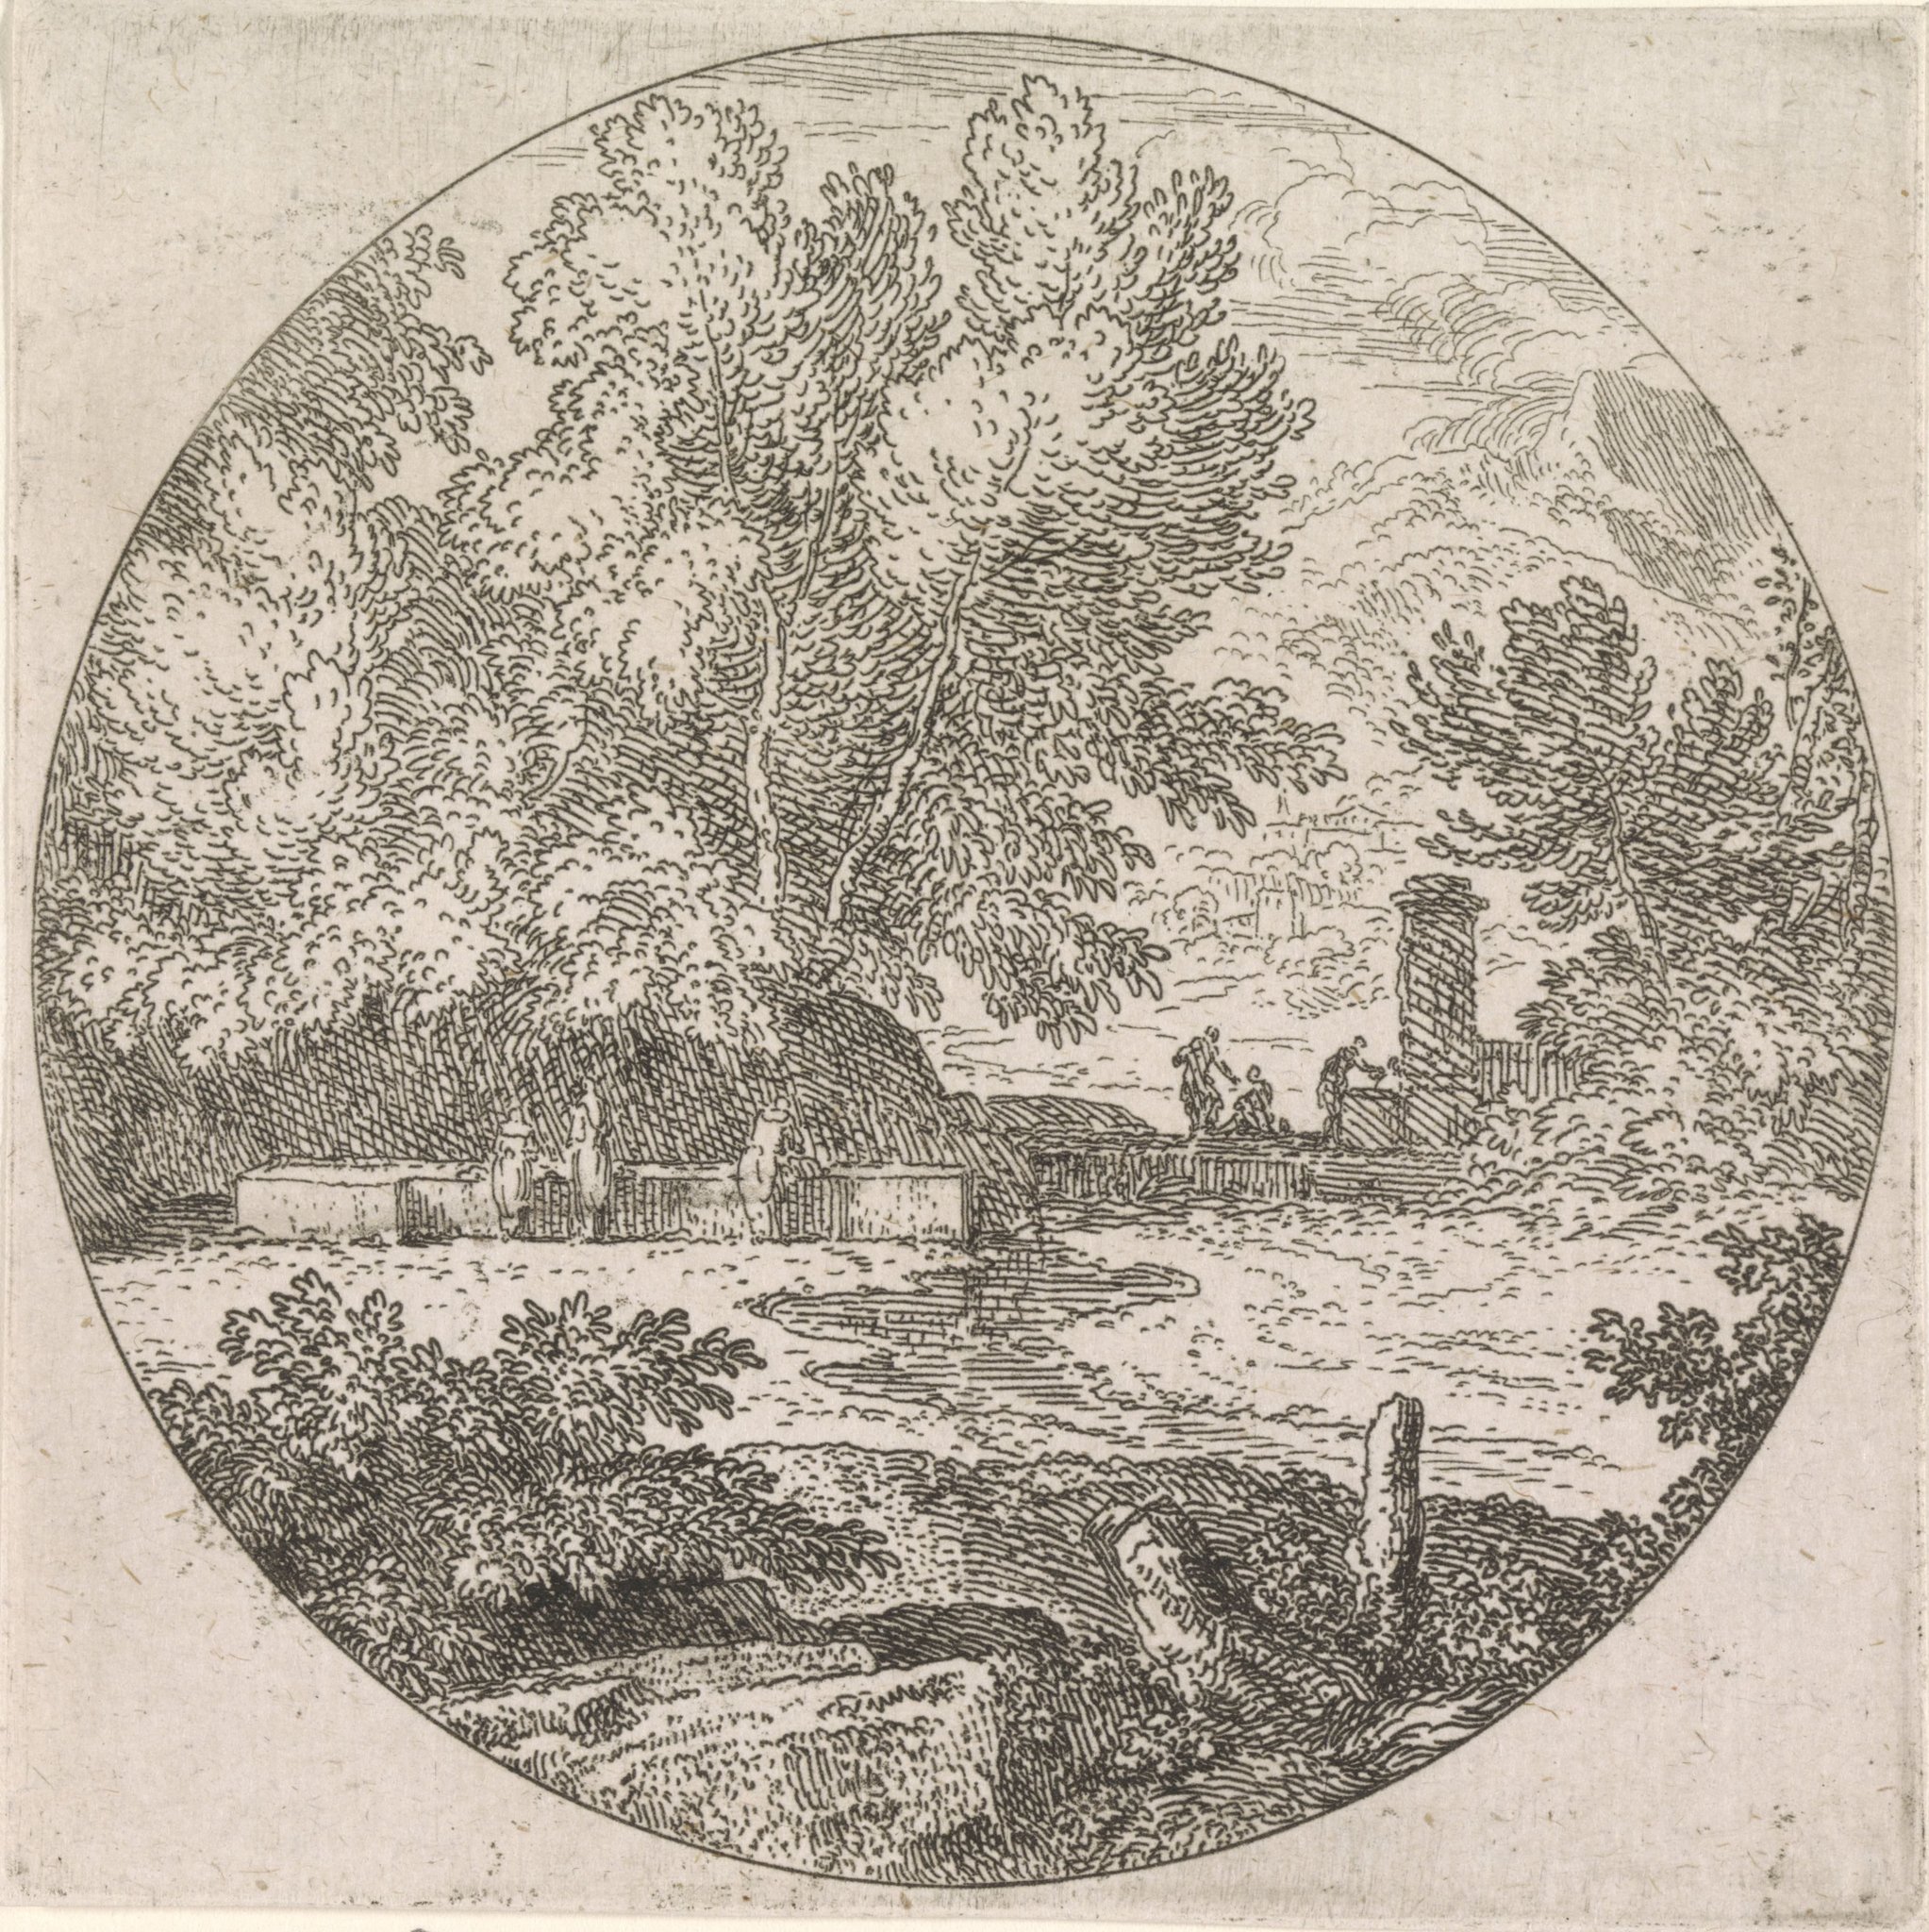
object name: print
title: Landschap met met enkele figuren bij een waterbron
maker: abraham genoels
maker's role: draughtsman, print maker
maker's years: 1640-1723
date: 1650-1723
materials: paper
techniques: etching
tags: well, forest, wood (+ landscape with figures, staffage)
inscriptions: collector's mark: Lugt 240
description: Een bebost landschap met enkele figuren bij een waterbron.